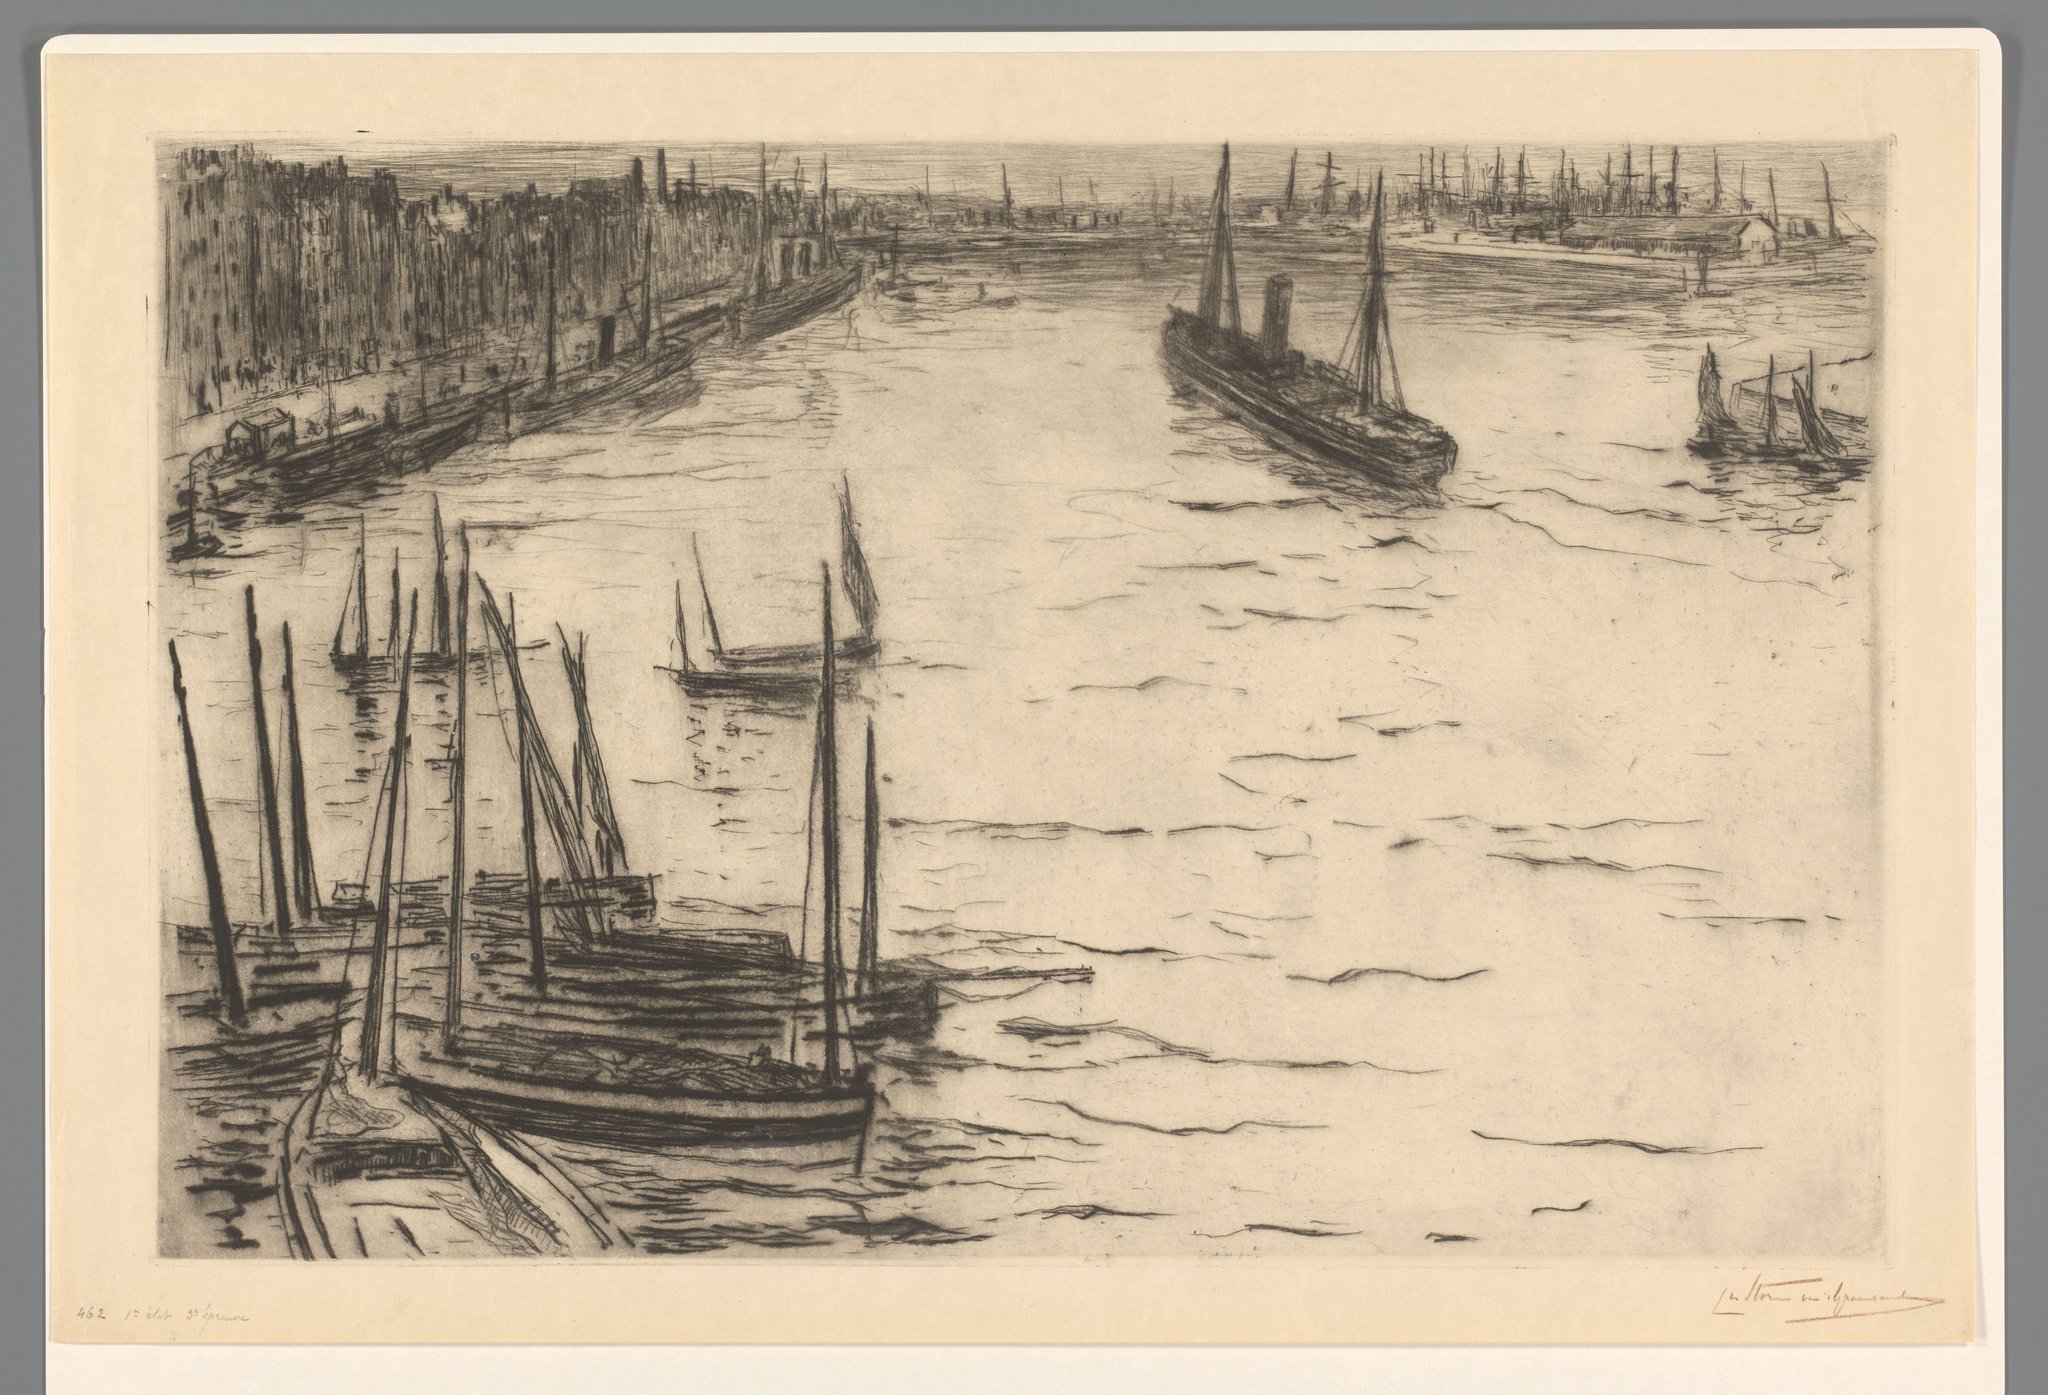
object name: print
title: Havengezicht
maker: carel nicolaas storm van s-gravesande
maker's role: draughtsman, print maker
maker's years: 1841-1924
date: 1889-1903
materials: paper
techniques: drypoint, intaglio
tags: harbour, sailing-ship, sailing-boat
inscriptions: collector's mark: Lugt 2228, annotation: ‘3e épreuve’